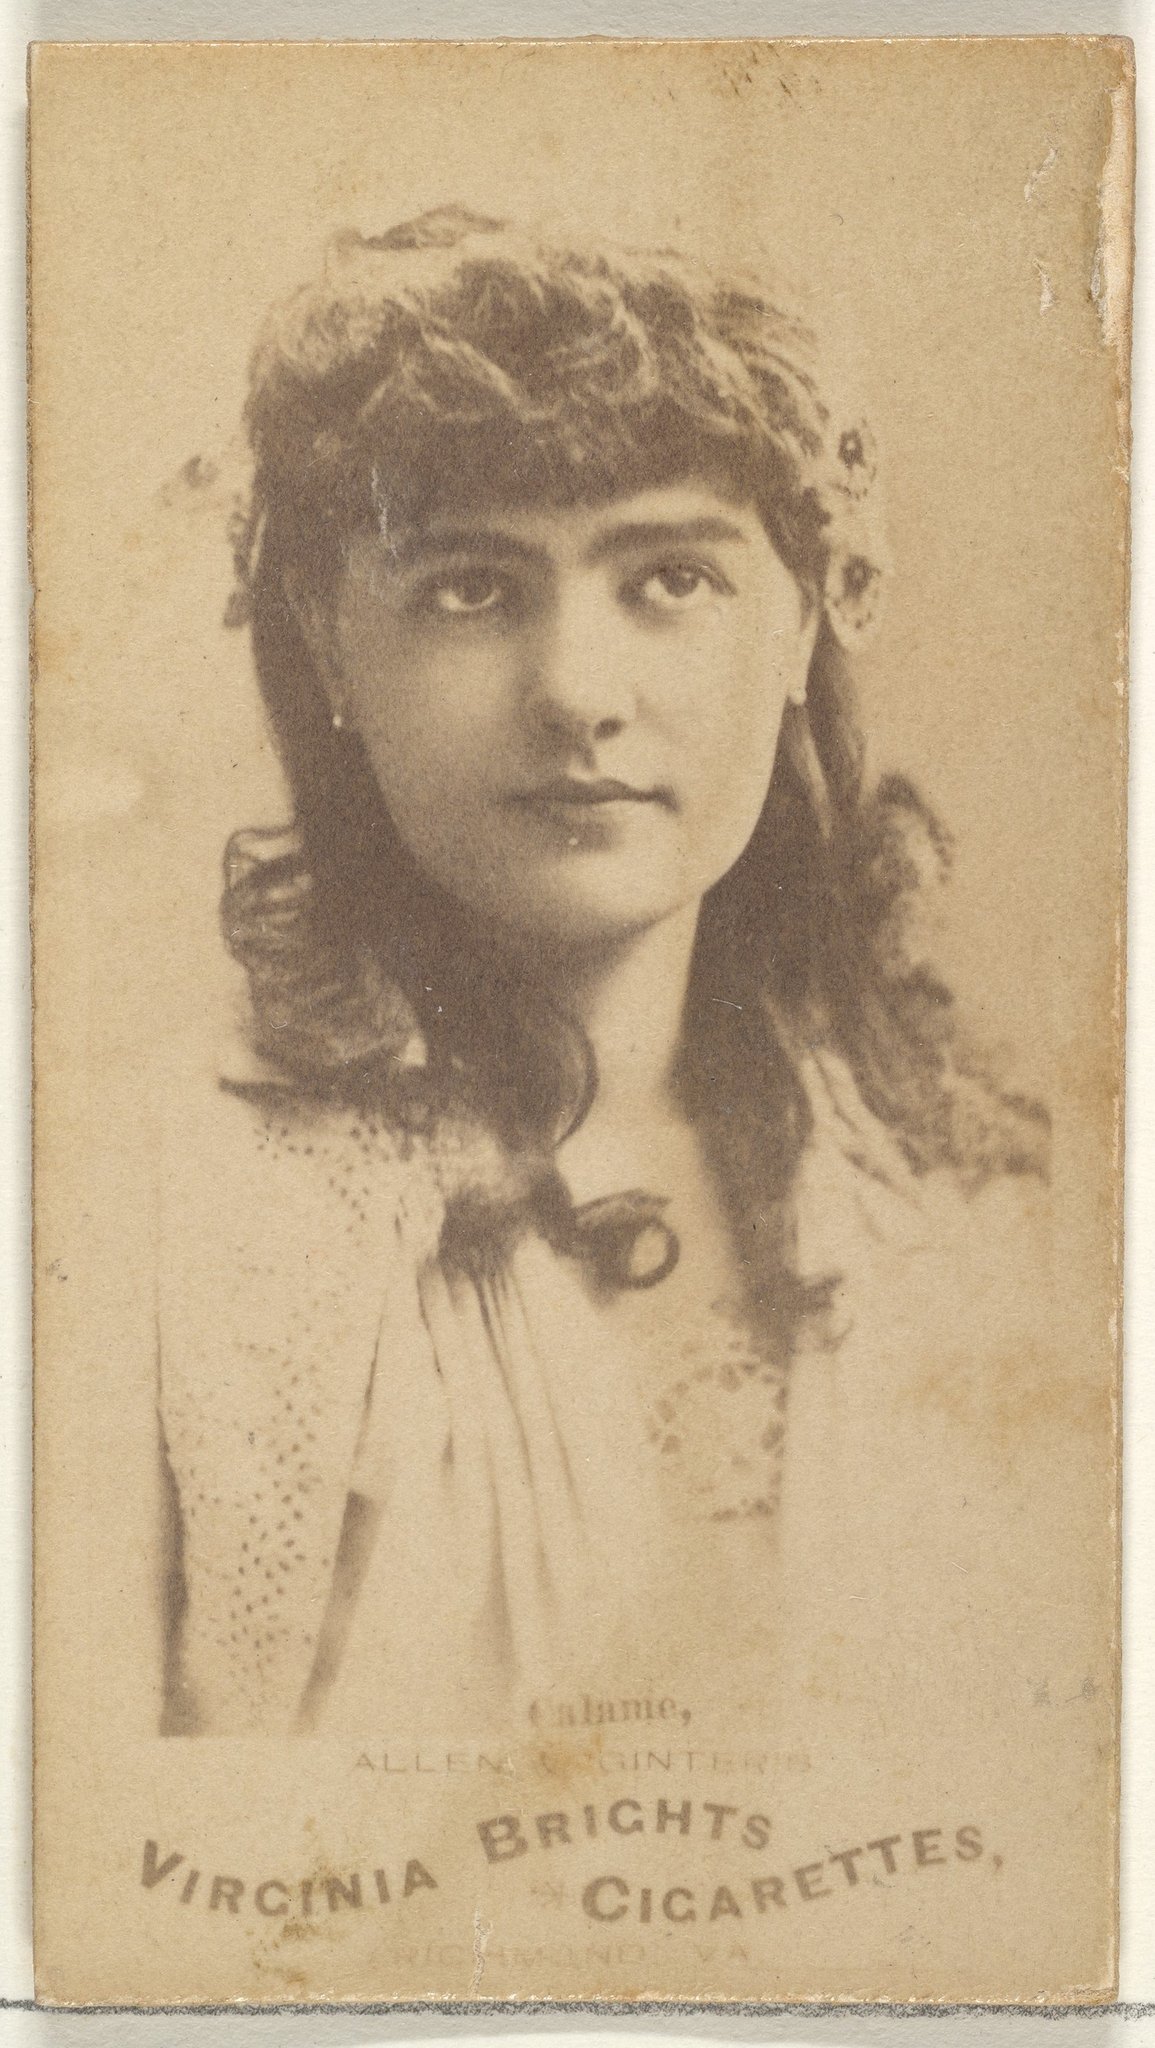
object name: photograph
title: Calanie, from the Actors and Actresses series (N45, Type 1) for Virginia Brights Cigarettes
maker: allen & ginter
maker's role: publisher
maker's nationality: american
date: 1888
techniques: albumen silver print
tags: portraits,women,actresses